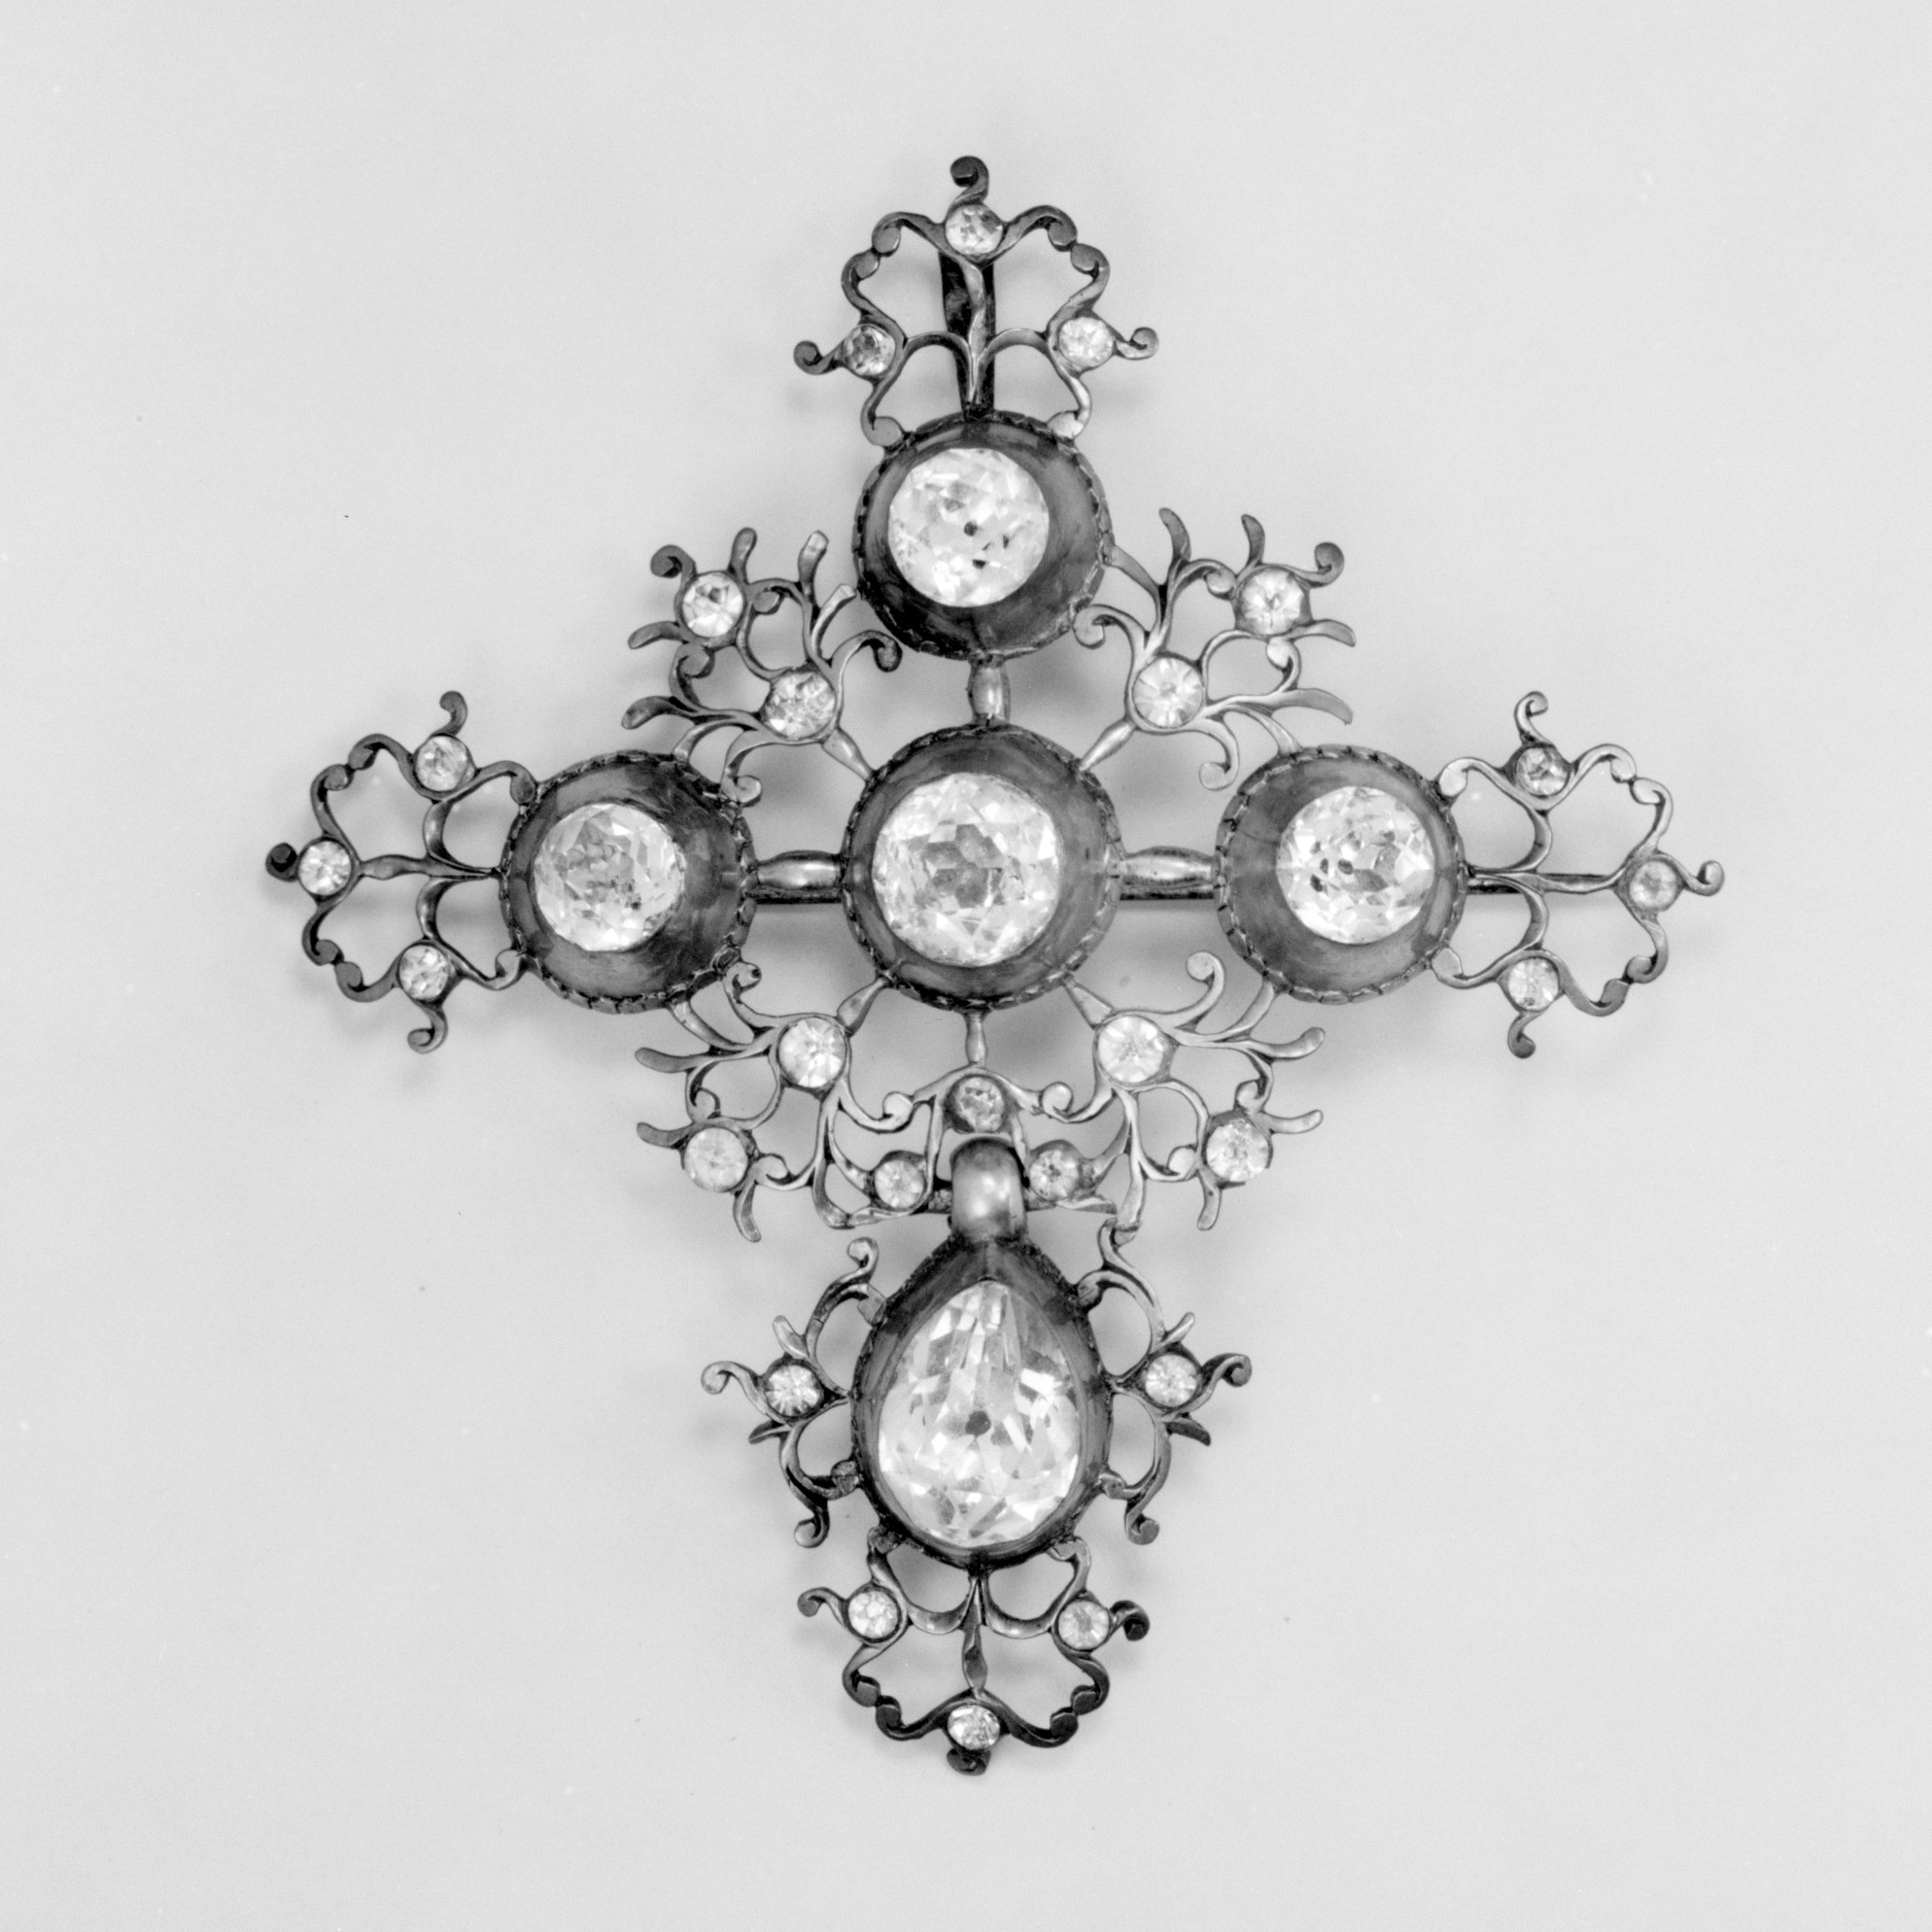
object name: cross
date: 1701-1800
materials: diamond, silver